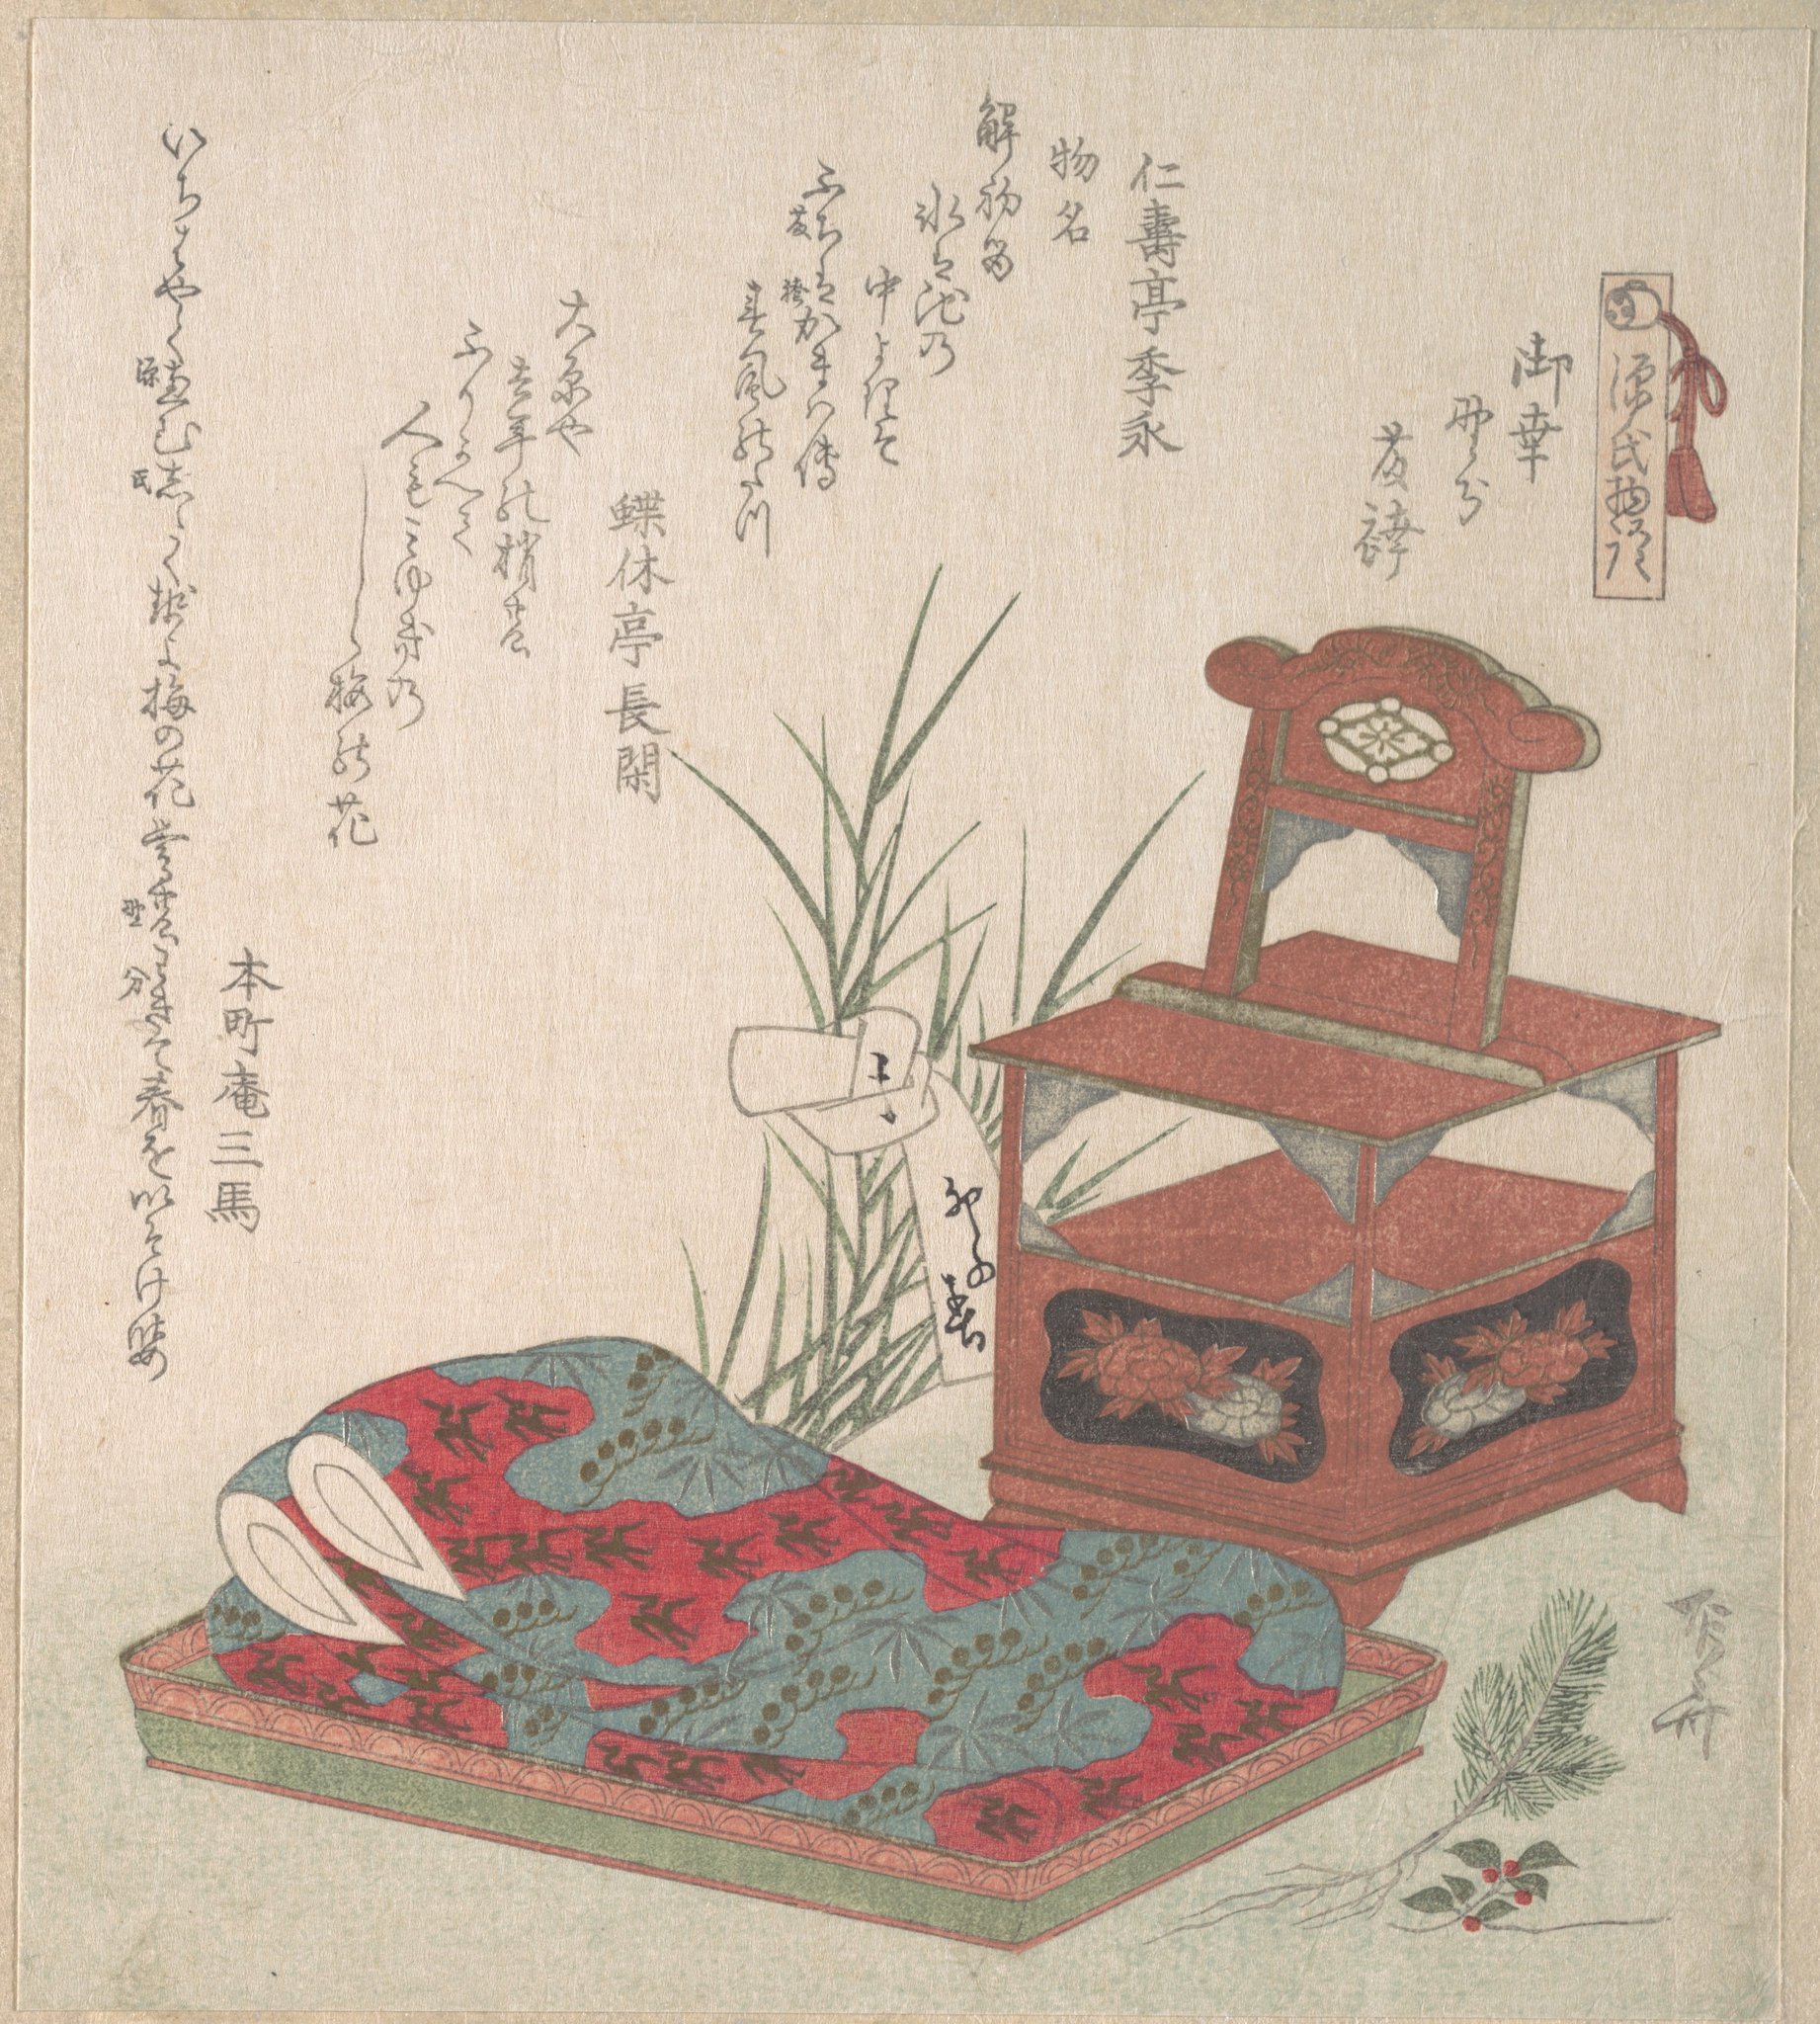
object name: woodblock print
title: Cabinet for the Toilet and Bed-Clothes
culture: japanese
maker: ryūryūkyo shinsai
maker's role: artist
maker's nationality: japanese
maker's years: 1799-1823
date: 1819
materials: ink, paper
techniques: surimono, woodblock print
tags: cabinets